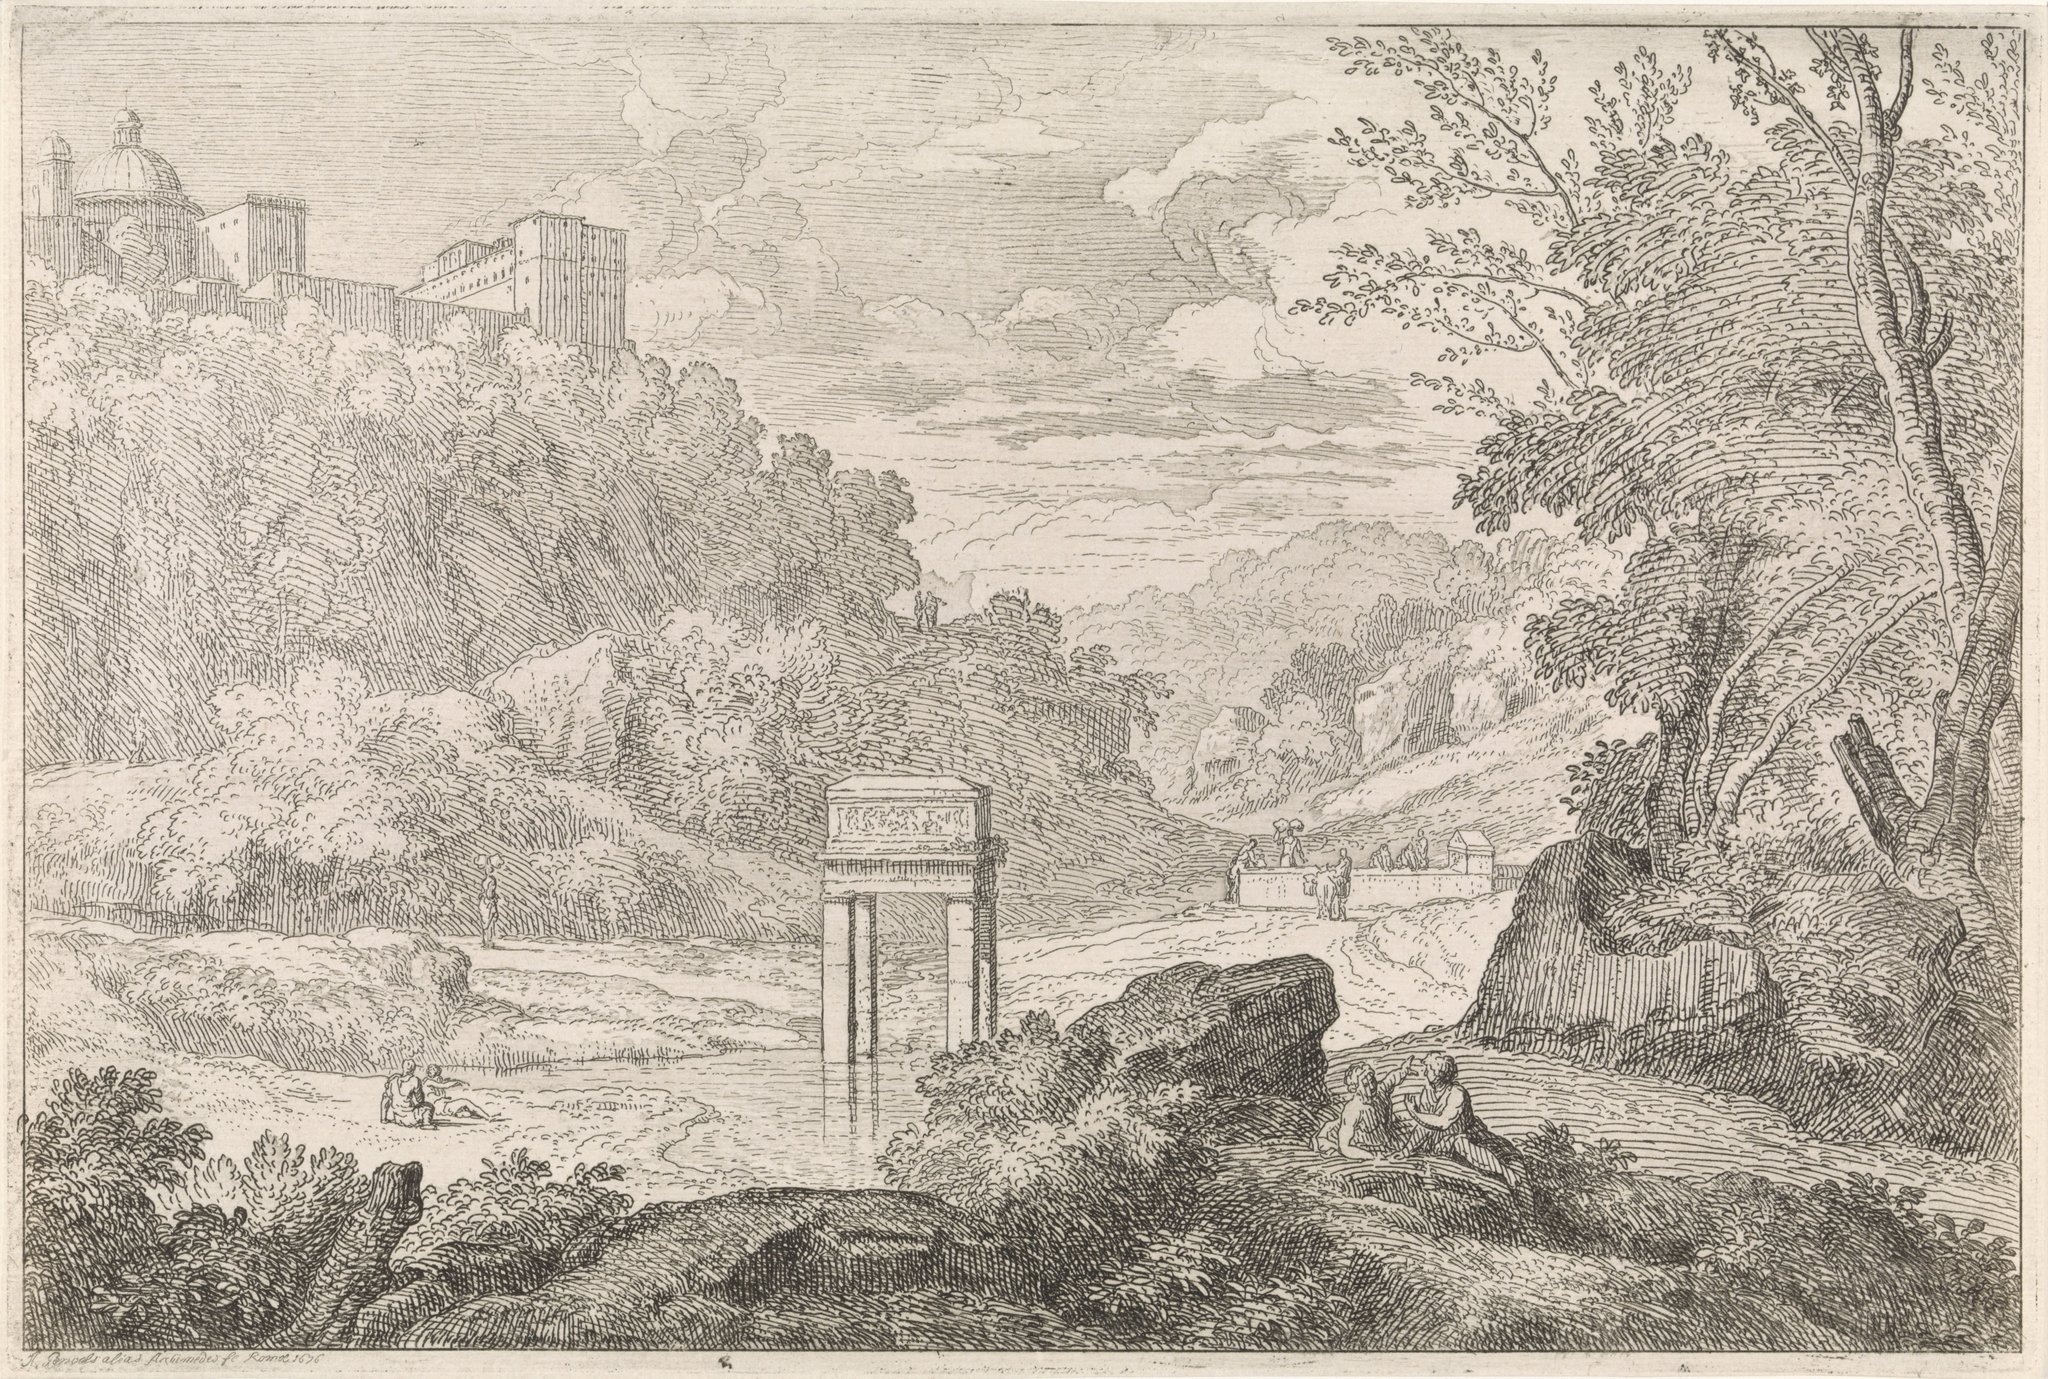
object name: print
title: Graftombe in een vijver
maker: abraham genoels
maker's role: draughtsman, print maker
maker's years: 1640-1723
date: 1679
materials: paper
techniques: etching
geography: rome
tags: well, grave, tomb, pastorals, arcadian scenes, pond, pool (+ landscape with figures, staffage)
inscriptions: collector's mark: Lugt 240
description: Een arcadisch landschap met een vijver. In de vijver staat op vier pilaren een graftombe. Op de achtergrond een waterbron met reizigers.